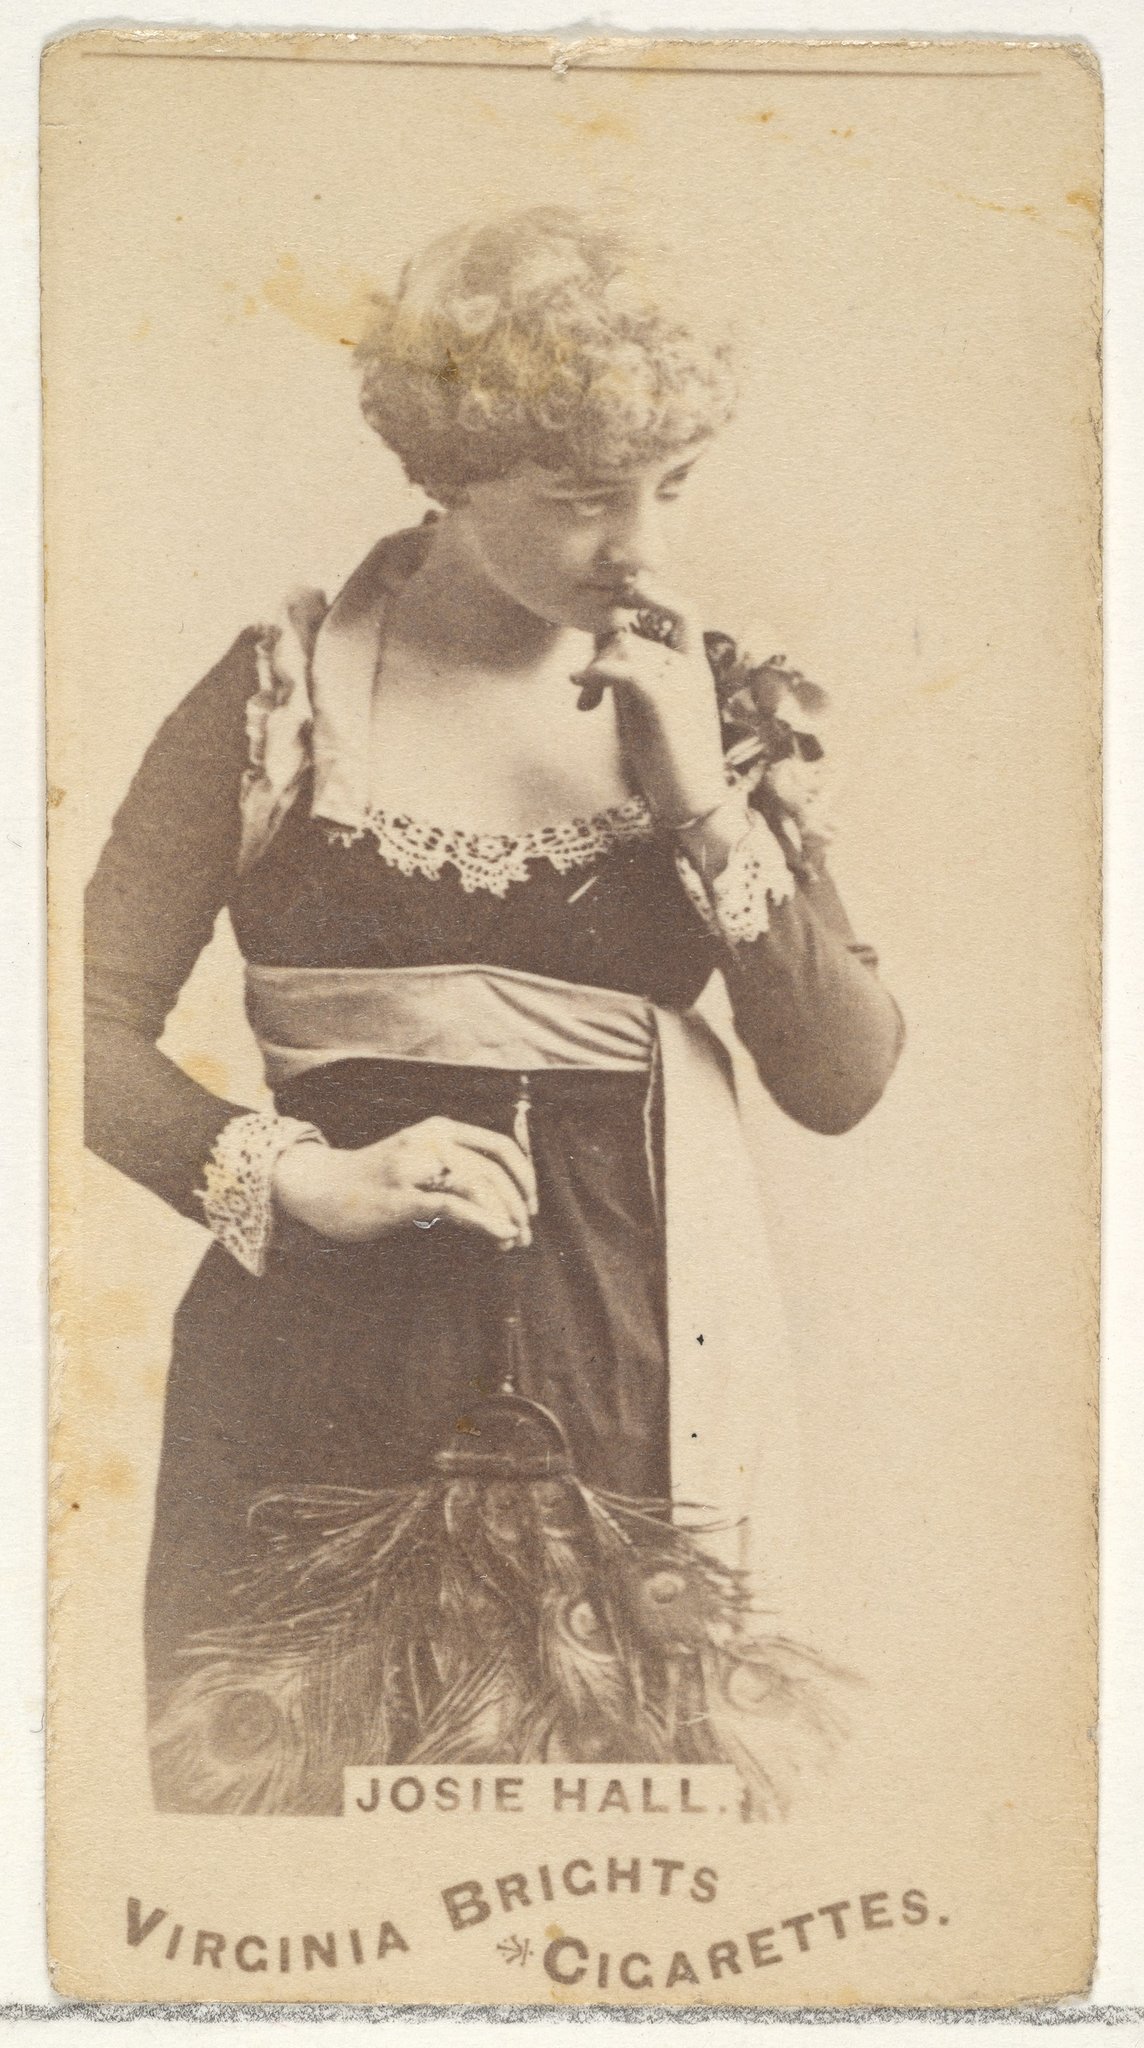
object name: photograph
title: Josie Hall, from the Actors and Actresses series (N45, Type 1) for Virginia Brights Cigarettes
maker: allen & ginter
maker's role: publisher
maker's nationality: american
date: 1888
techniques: albumen silver print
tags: portraits,women,actresses